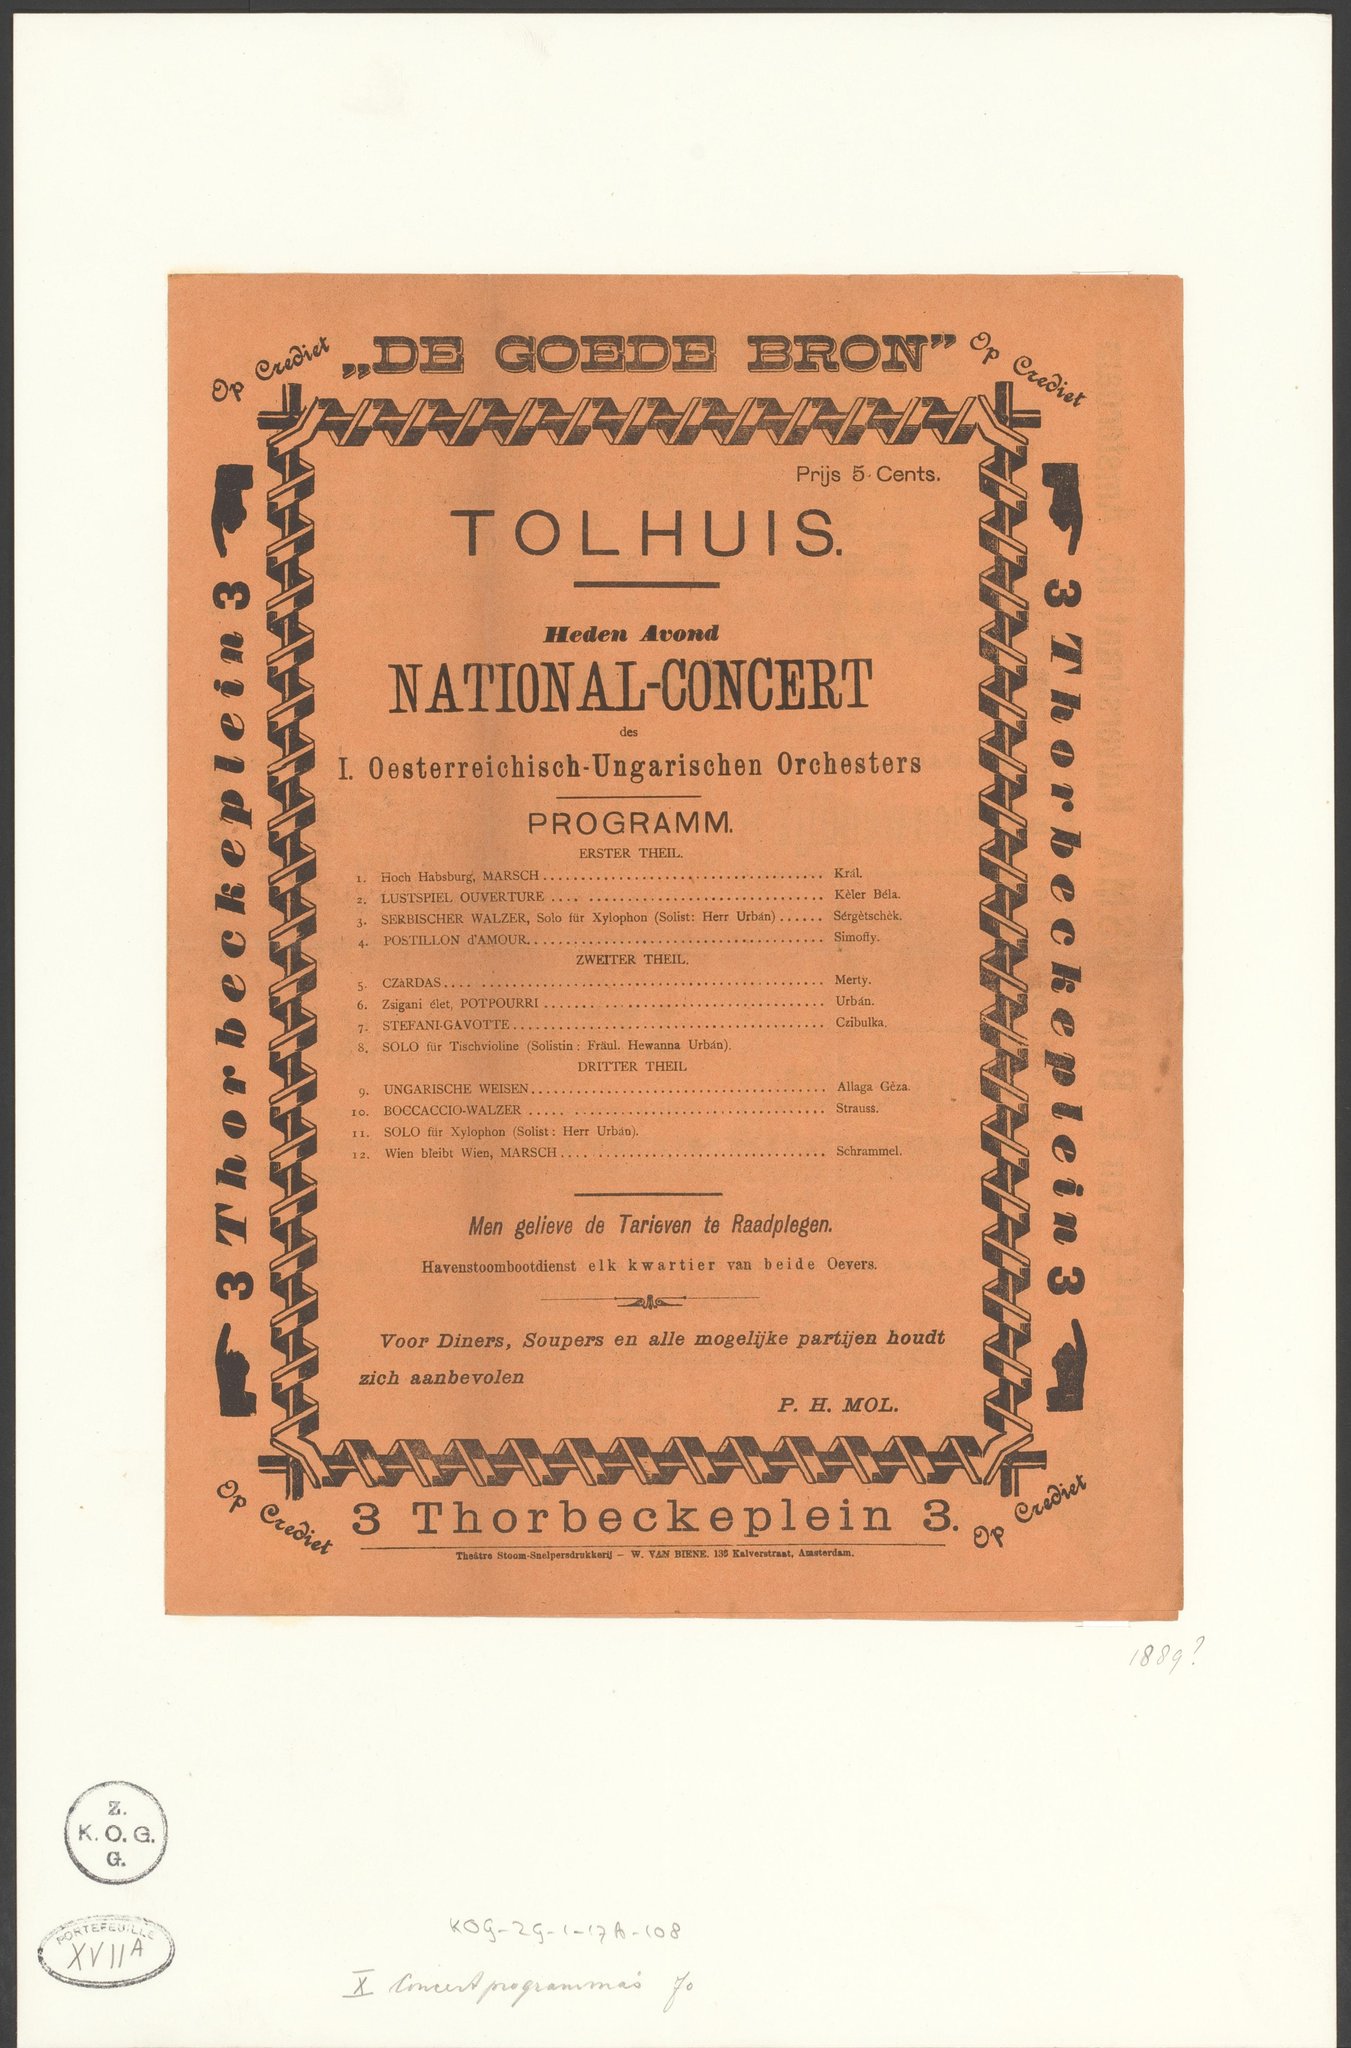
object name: advertisement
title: Programma voor een uitvoering 'Heden Avond' van een concert in het Tolhuis te Amsterdam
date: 1889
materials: paper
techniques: letterpress printing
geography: amsterdam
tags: listening to music, large group of musicians, orchestra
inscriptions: collector's mark: Lugt 1641, collector's mark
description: Gedrukt programma voor een uitvoering van een concert door het 'Oesterreichisch-Ungarischen Orchesters' in het Tolhuis te Amsterdam. Op het programma staat ook de naam van Verkoophuis 'Op Crediet' 'De Goede Bron', met het adres Thorbeckeplein 3 vermeld. Zonder datum. Mogelijk 1889. Dubbelgevouwen blad van oranje papier bedrukt binnenin en op verso met advertenties. Onderwerpsrubrieken binnen de Atlas Zeden en Gewoonten: Muziek en muziekinstrumenten: Varia.